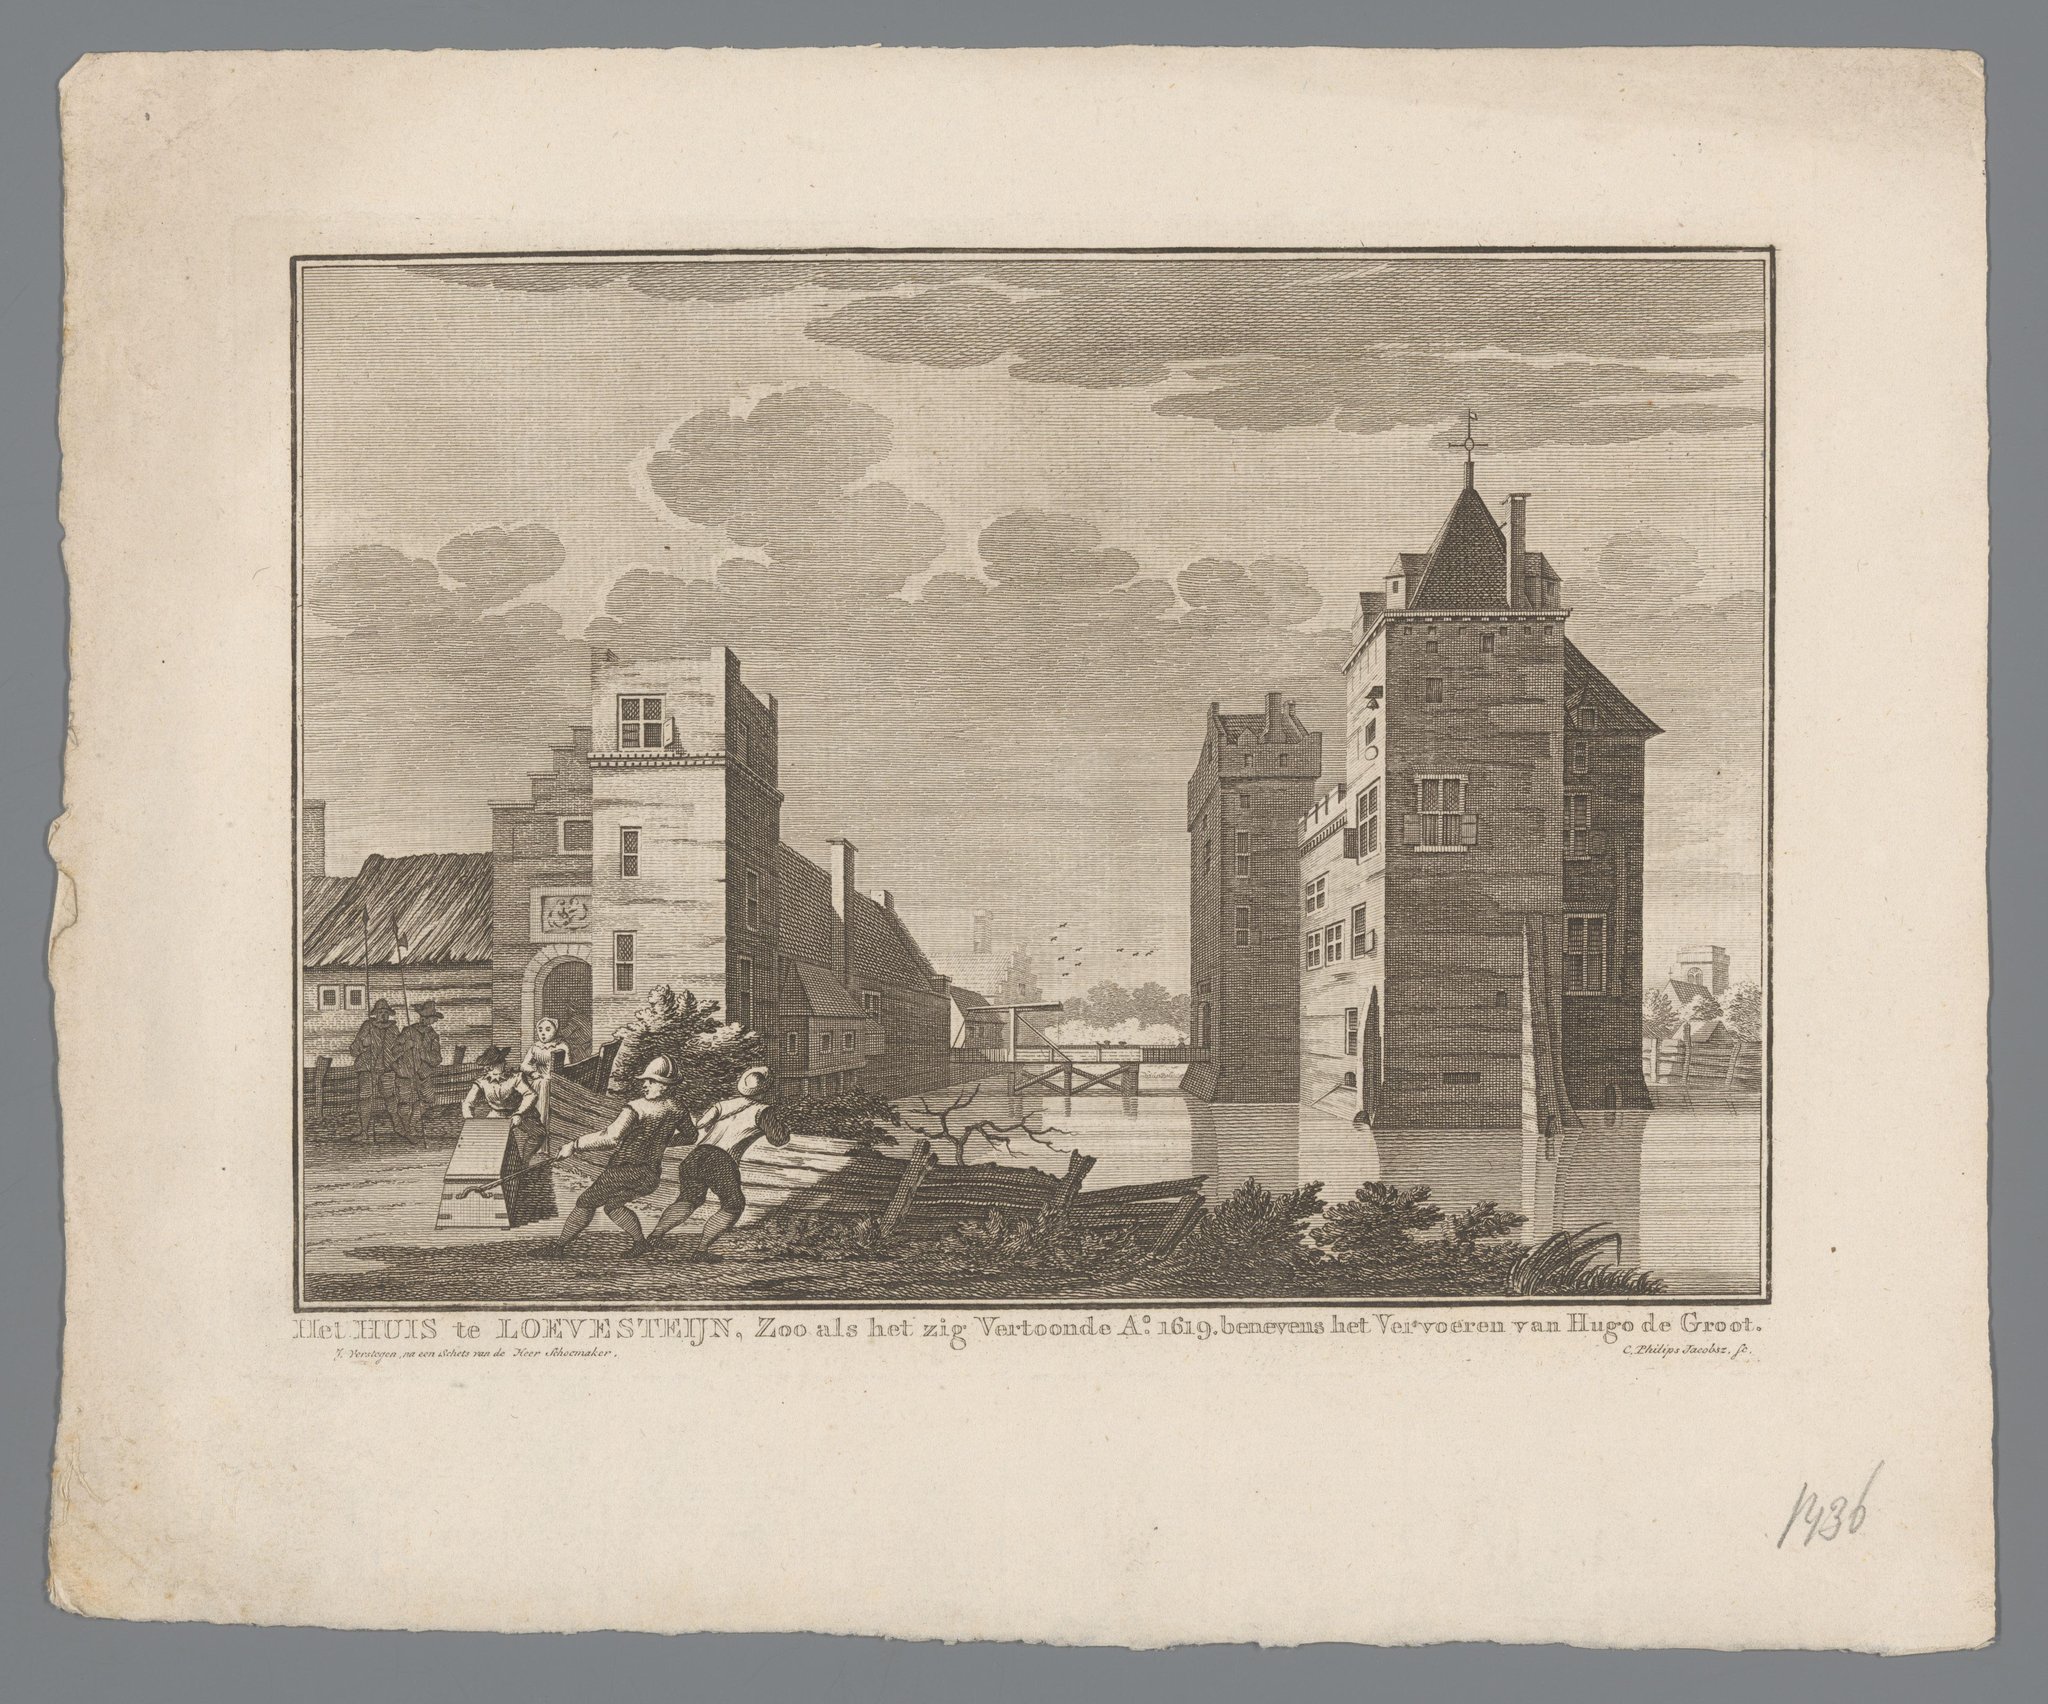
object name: print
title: Het Huis te Loevesteijn, zoo als het zig vertoonde Ao. 1619. benevens het vervoeren van Hugo de Groot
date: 1752-1789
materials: paper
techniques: etching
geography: amsterdam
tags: delft, hugo de groot, castle, landscape with tower or castle (+ city(-scape) with figures, staffage), law and jurisprudence (+ escape from prison), loevestein castle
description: Gezicht op Slot Loevestein met links op de voorgrond de ontsnapping van Hugo de Groot in de boekenkist, 22 maart 1621. Mannen slepen de kist aan een touw.